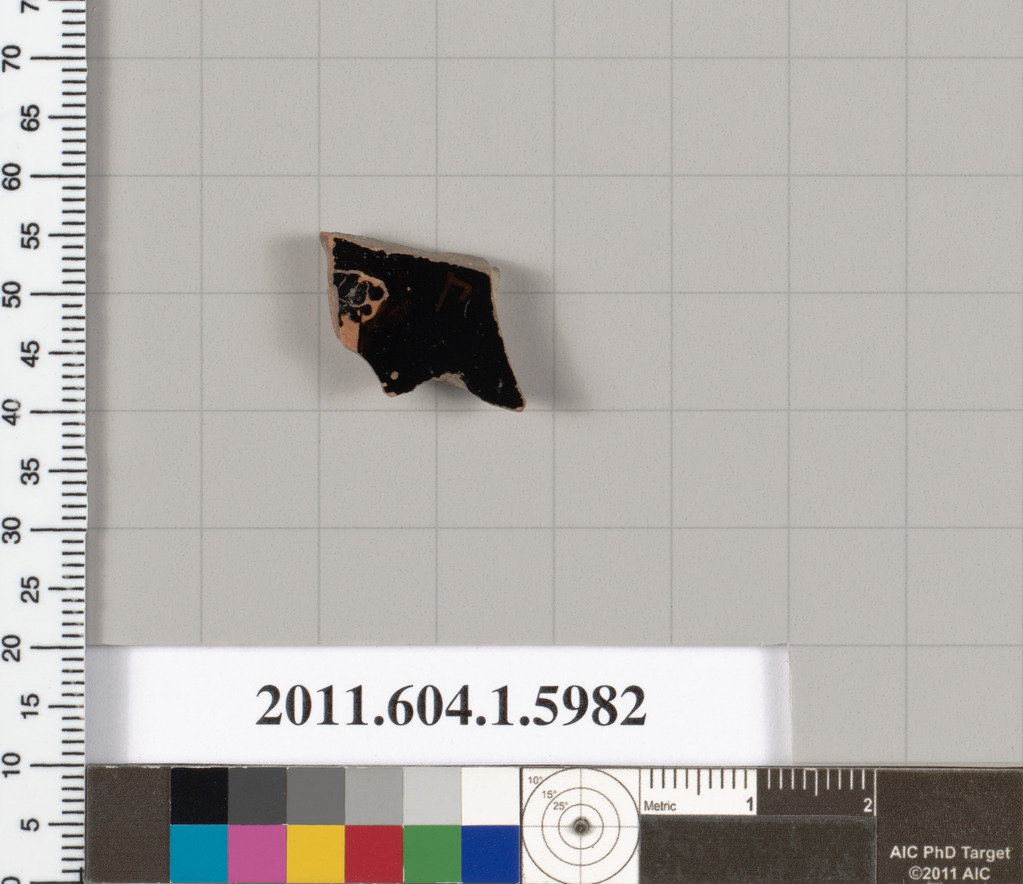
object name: kylix fragment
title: Terracotta fragment of a kylix (drinking cup)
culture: greek, attic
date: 510-500 BCE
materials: terracotta